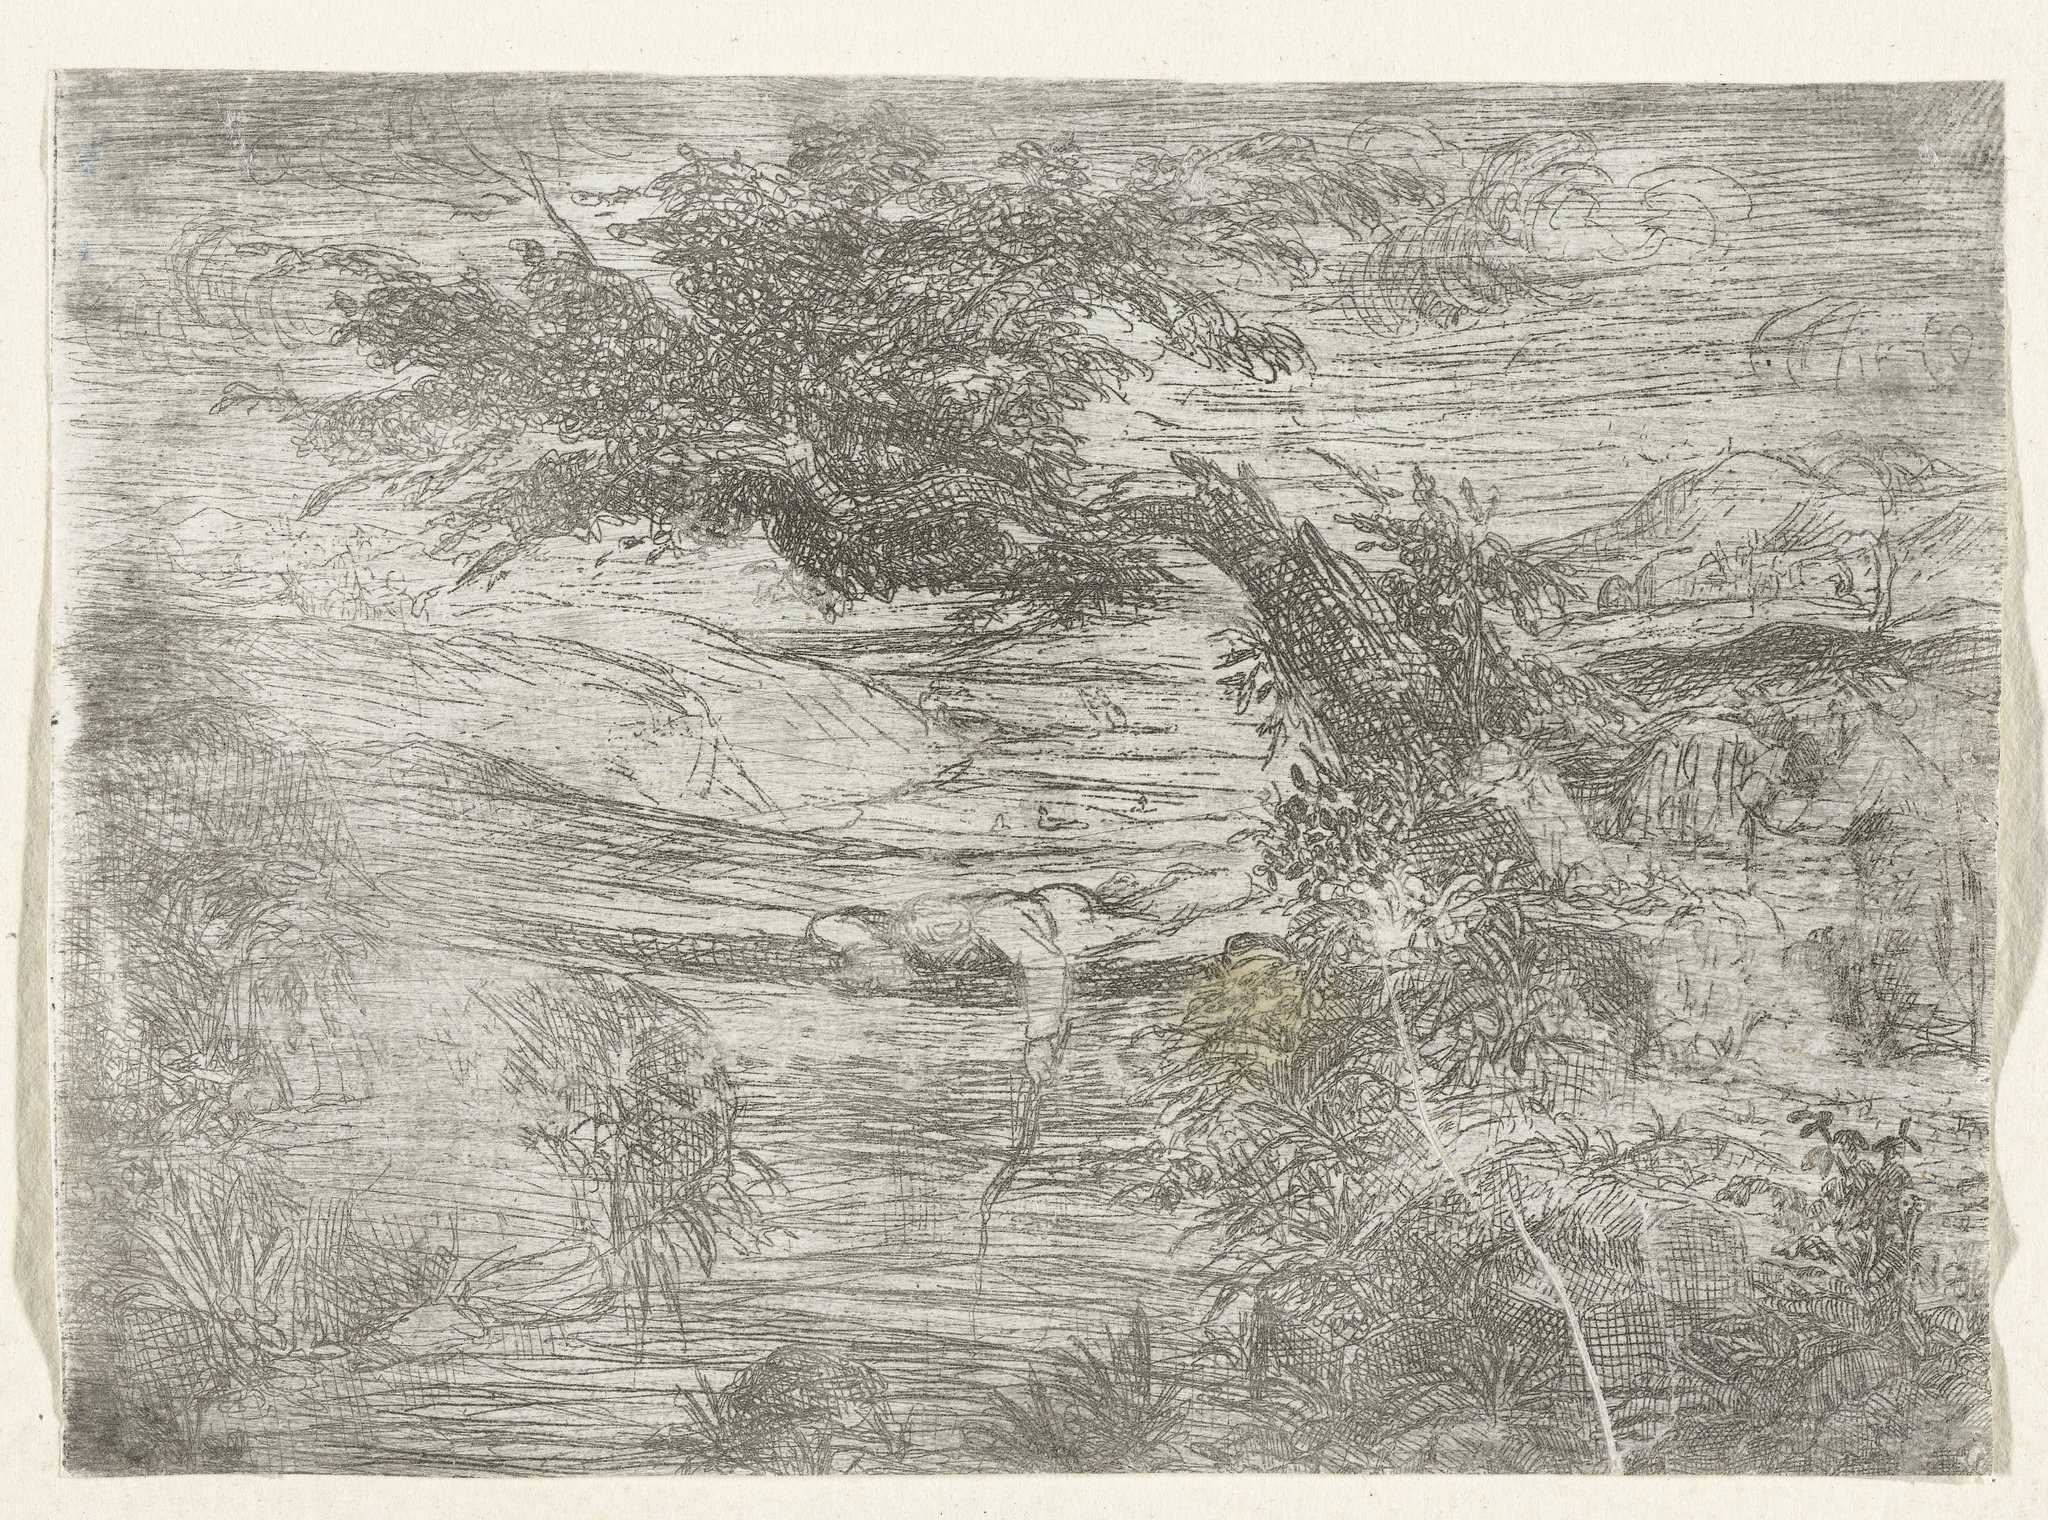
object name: print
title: Le pècheur sur le pont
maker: rodolphe bresdin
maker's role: draughtsman, print maker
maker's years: 1822-1885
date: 1843-1844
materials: paper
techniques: etching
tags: angling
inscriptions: collector's mark: Lugt 2194, collector's mark: Lugt 2228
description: Een man ligt op zijn buik op de oever van een water te vissen vlakbij een boom.